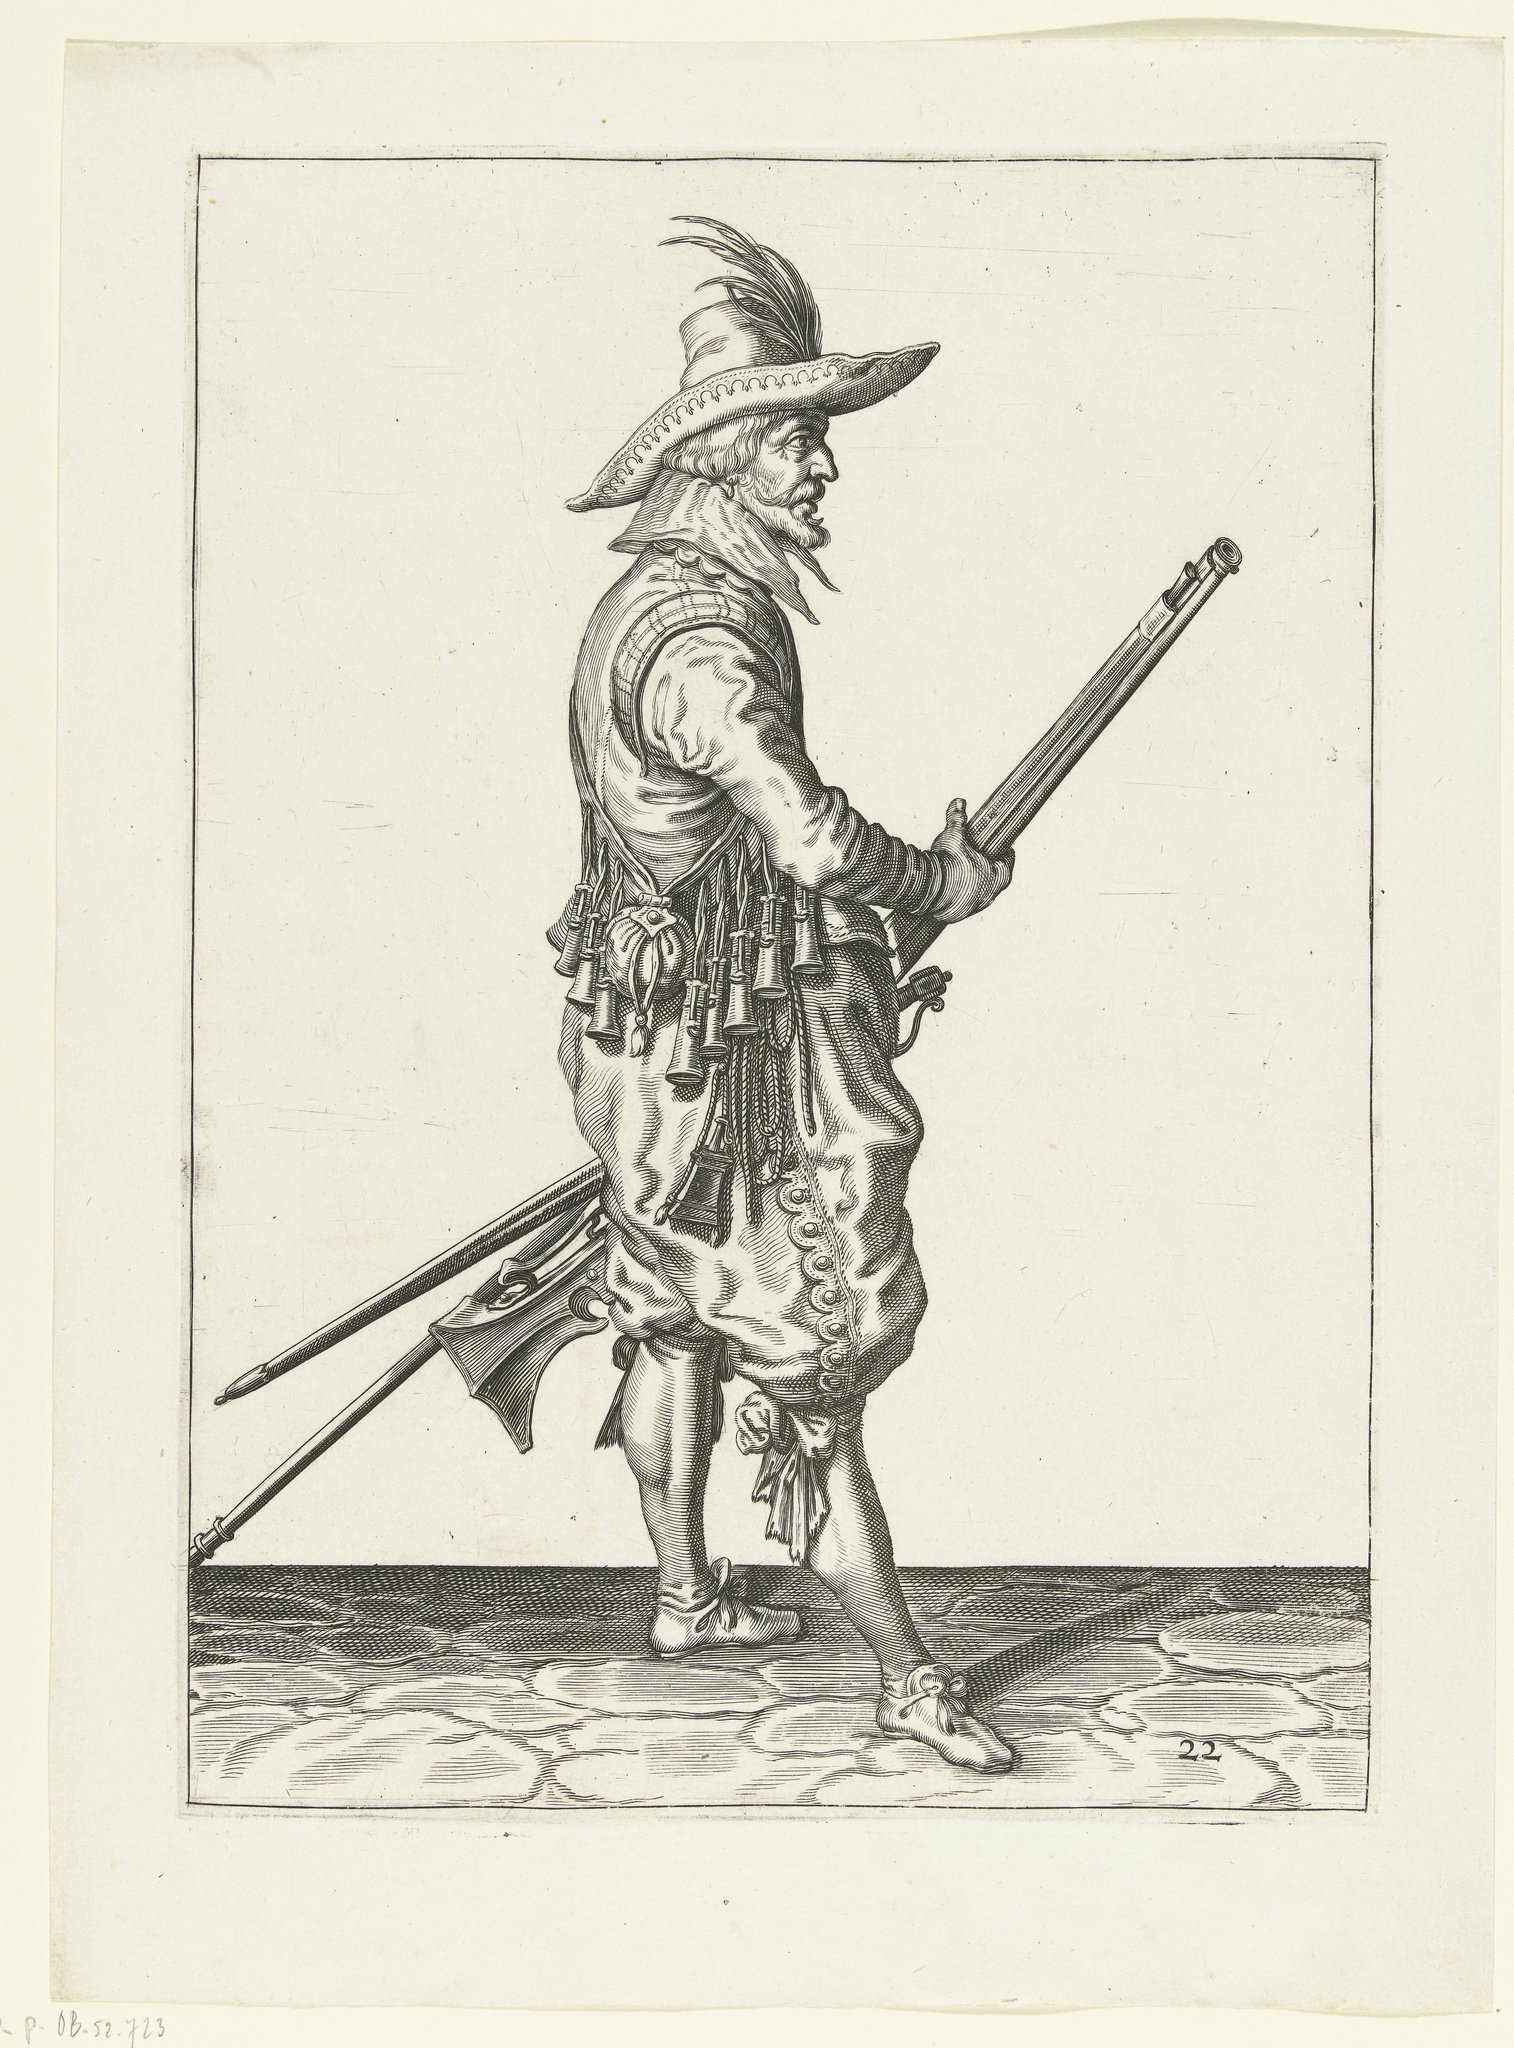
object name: print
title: Soldaat die zijn musket met beide handen bij zijn linkerdijbeen vasthoudt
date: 1597-1607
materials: paper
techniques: engraving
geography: netherlands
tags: manoeuvre ~ military training, firearms: rifle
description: Een soldaat, ten voeten uit, naar rechts, die met beide handen bij zijn linkerdijbeen een musket (een bepaald type vuurwapen) vasthoudt. In zijn linkerhand behalve het musket ook een furket (musketvork). Deze prent is onderdeel van de reeks van 43 genummerde prenten van musketiers uit de Wapenhandelinghe.